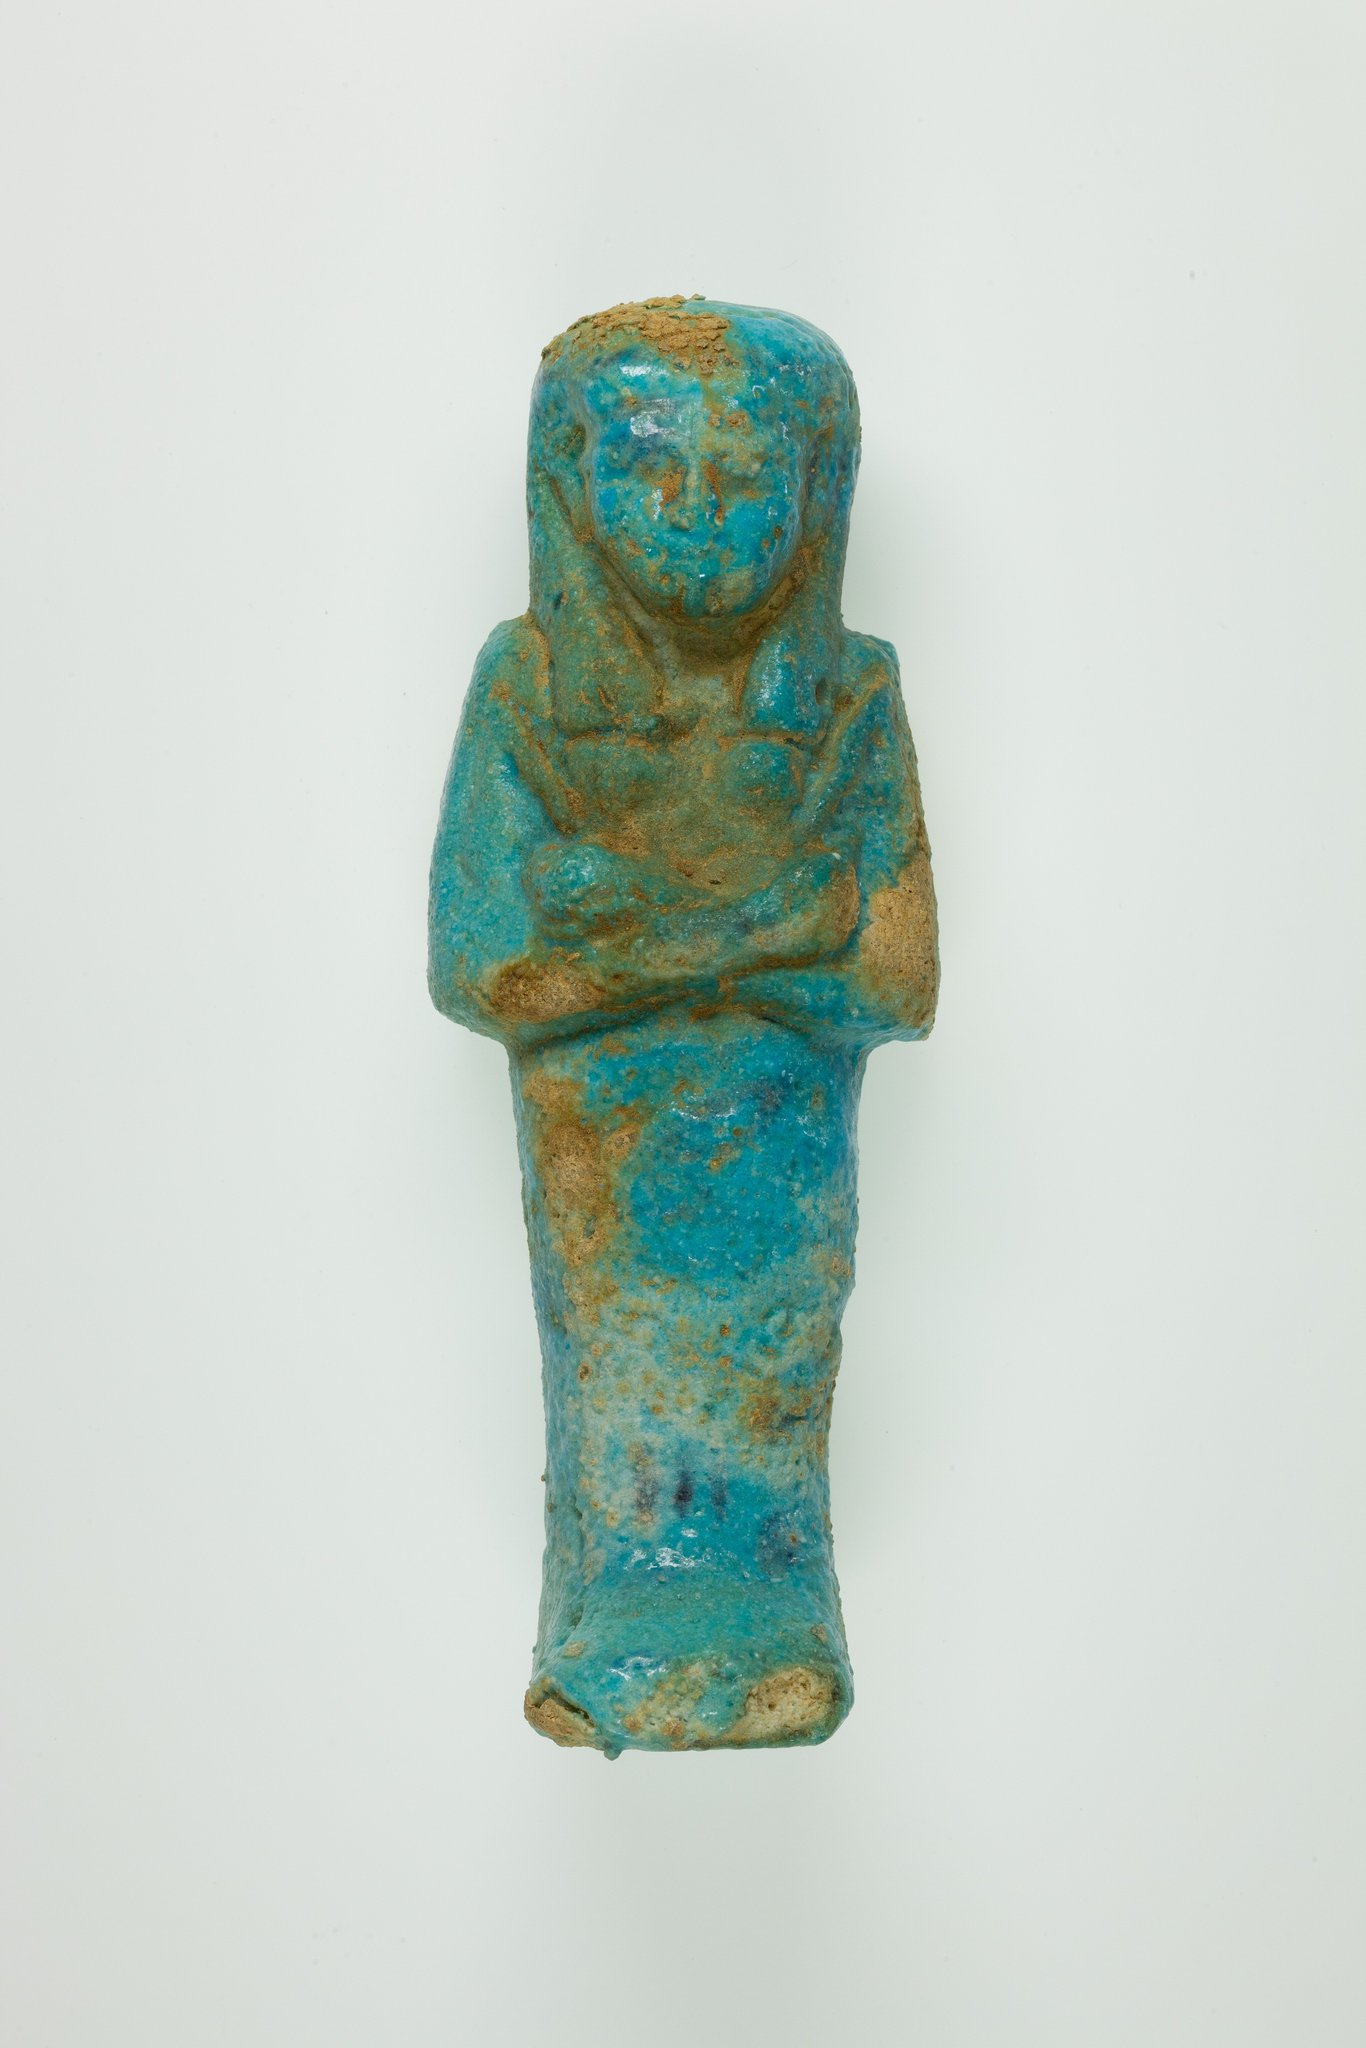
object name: worker shabti, henettawy c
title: Worker Shabti of Henettawy (C), Daughter of Isetemkheb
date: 990-970 BCE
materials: faience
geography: egypt